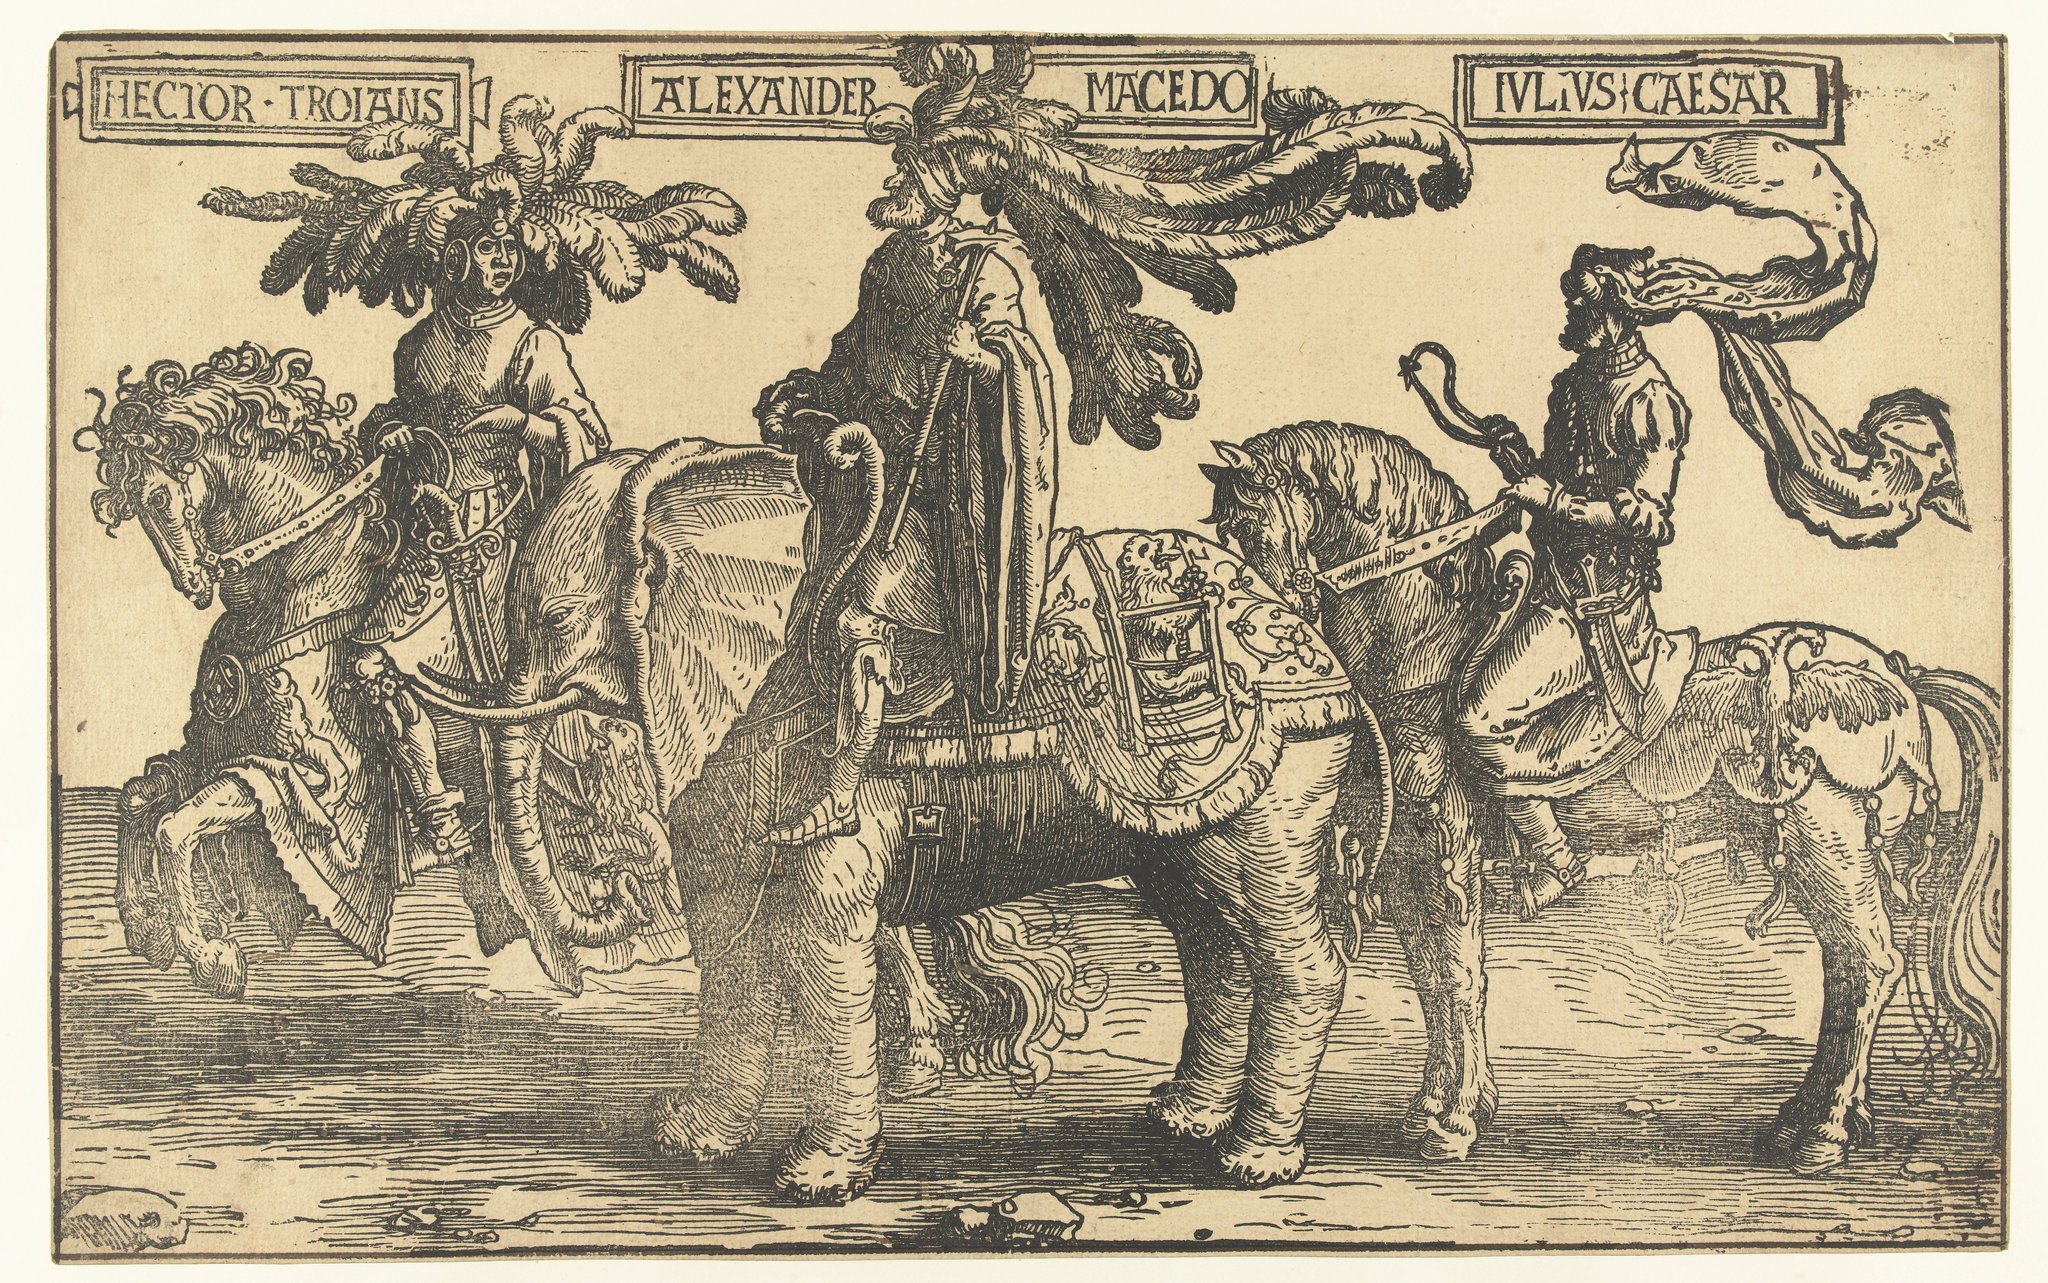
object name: print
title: De negen helden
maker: lucas van leyden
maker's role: draughtsman, painter, print maker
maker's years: 1494-1533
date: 1518-1522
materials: paper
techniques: brush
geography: low countries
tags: julius caesar (one of the nine worthies), alexander (one of the nine worthies), hector (one of the nine worthies)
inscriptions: collector's mark: Lugt 240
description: Eén van drie houtsneden, onderdeel van fries met negen helden. Drie helden uit de antieke oudheid: Hector van Troje en Julius Caesar te paard, Alexandre de Grote op een olifant. Boven alle drie kader met naam.